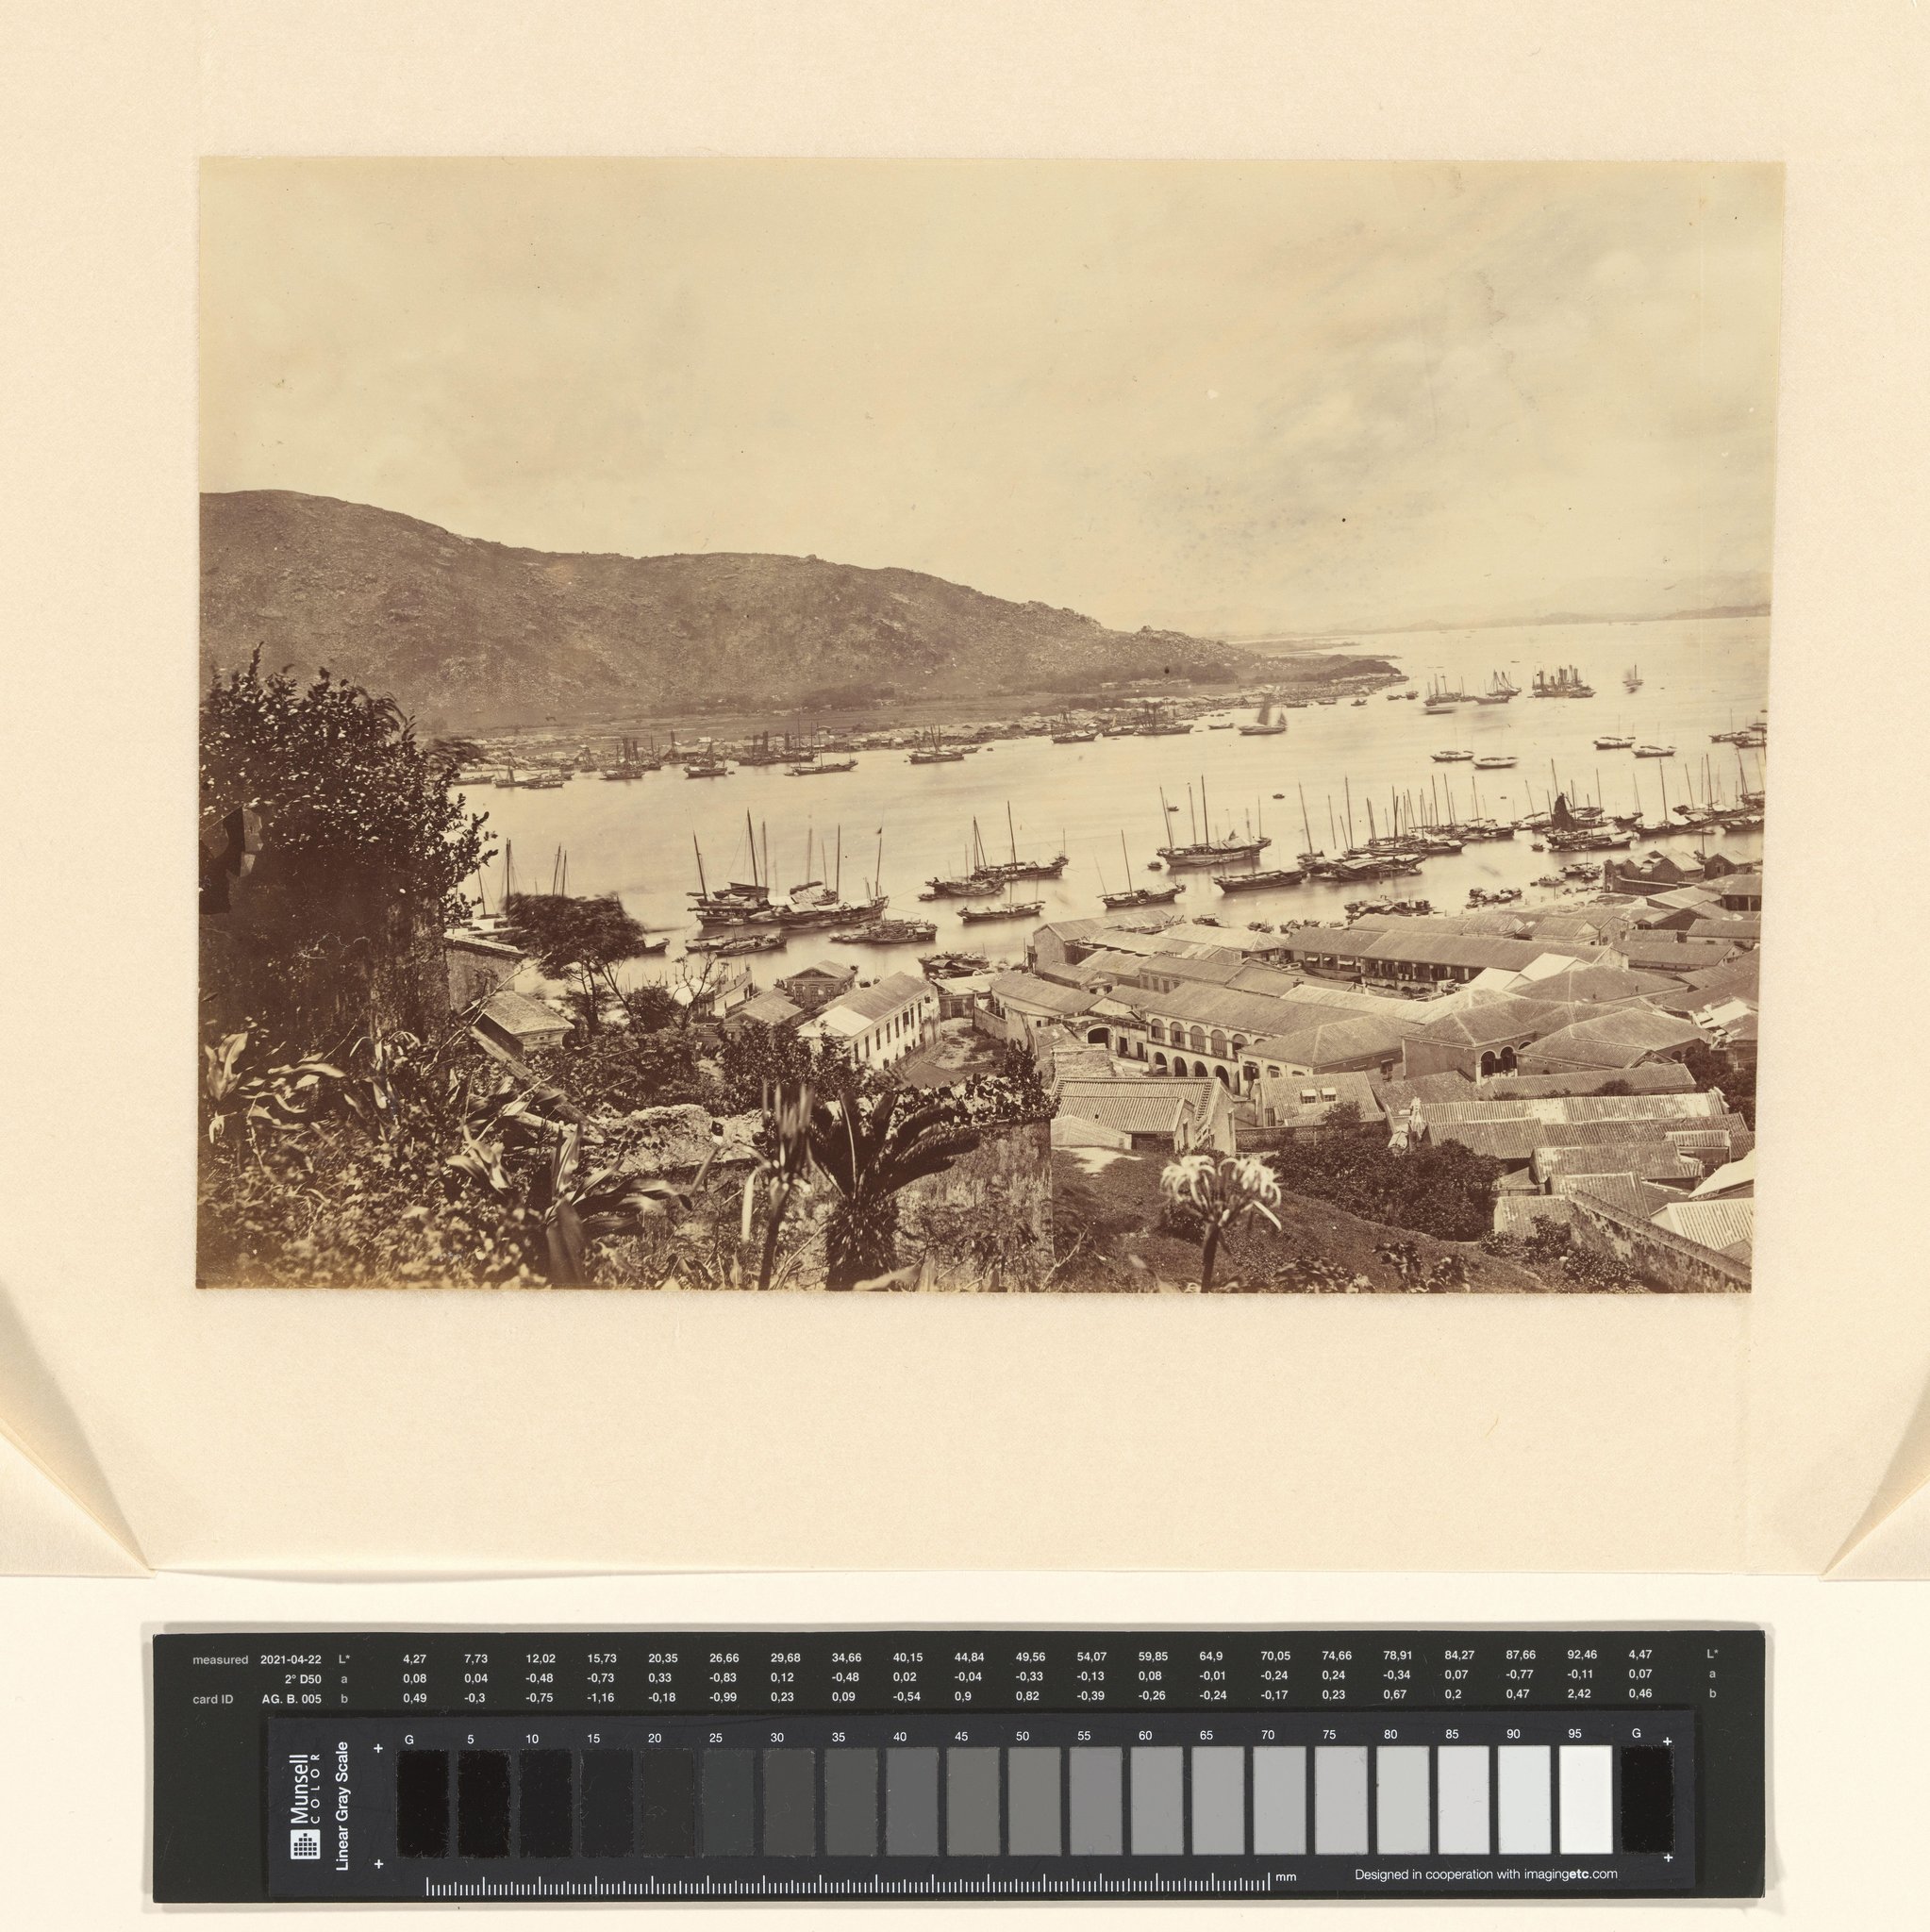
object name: photograph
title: Gezicht over Macau (?)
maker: Anonymous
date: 1865-1875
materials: paper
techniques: albumen print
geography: macau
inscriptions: number: ‘15’